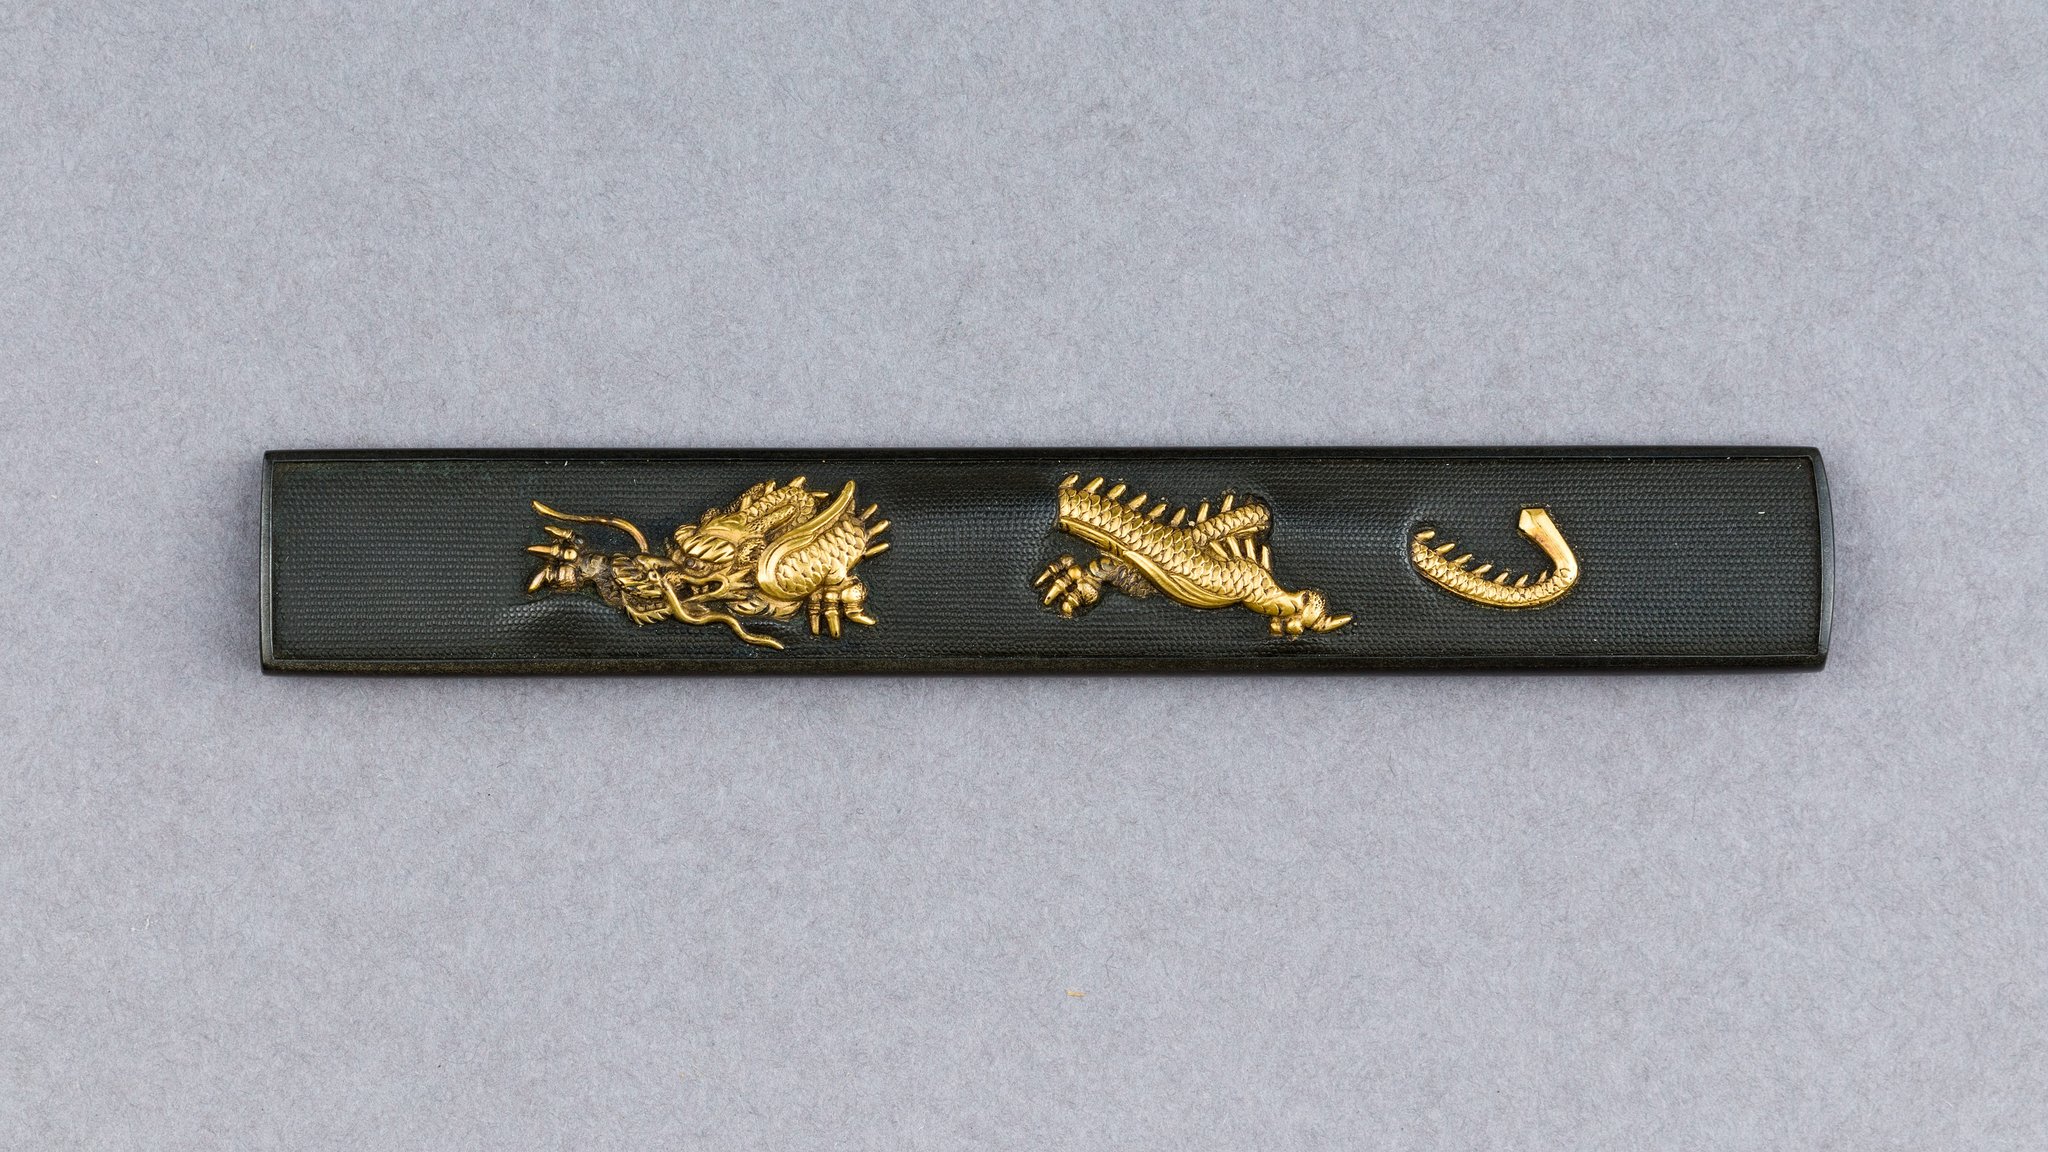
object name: knife handle kozuka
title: Knife Handle (Kozuka)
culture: japanese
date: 1615-1868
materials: gold alloy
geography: japan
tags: dragons